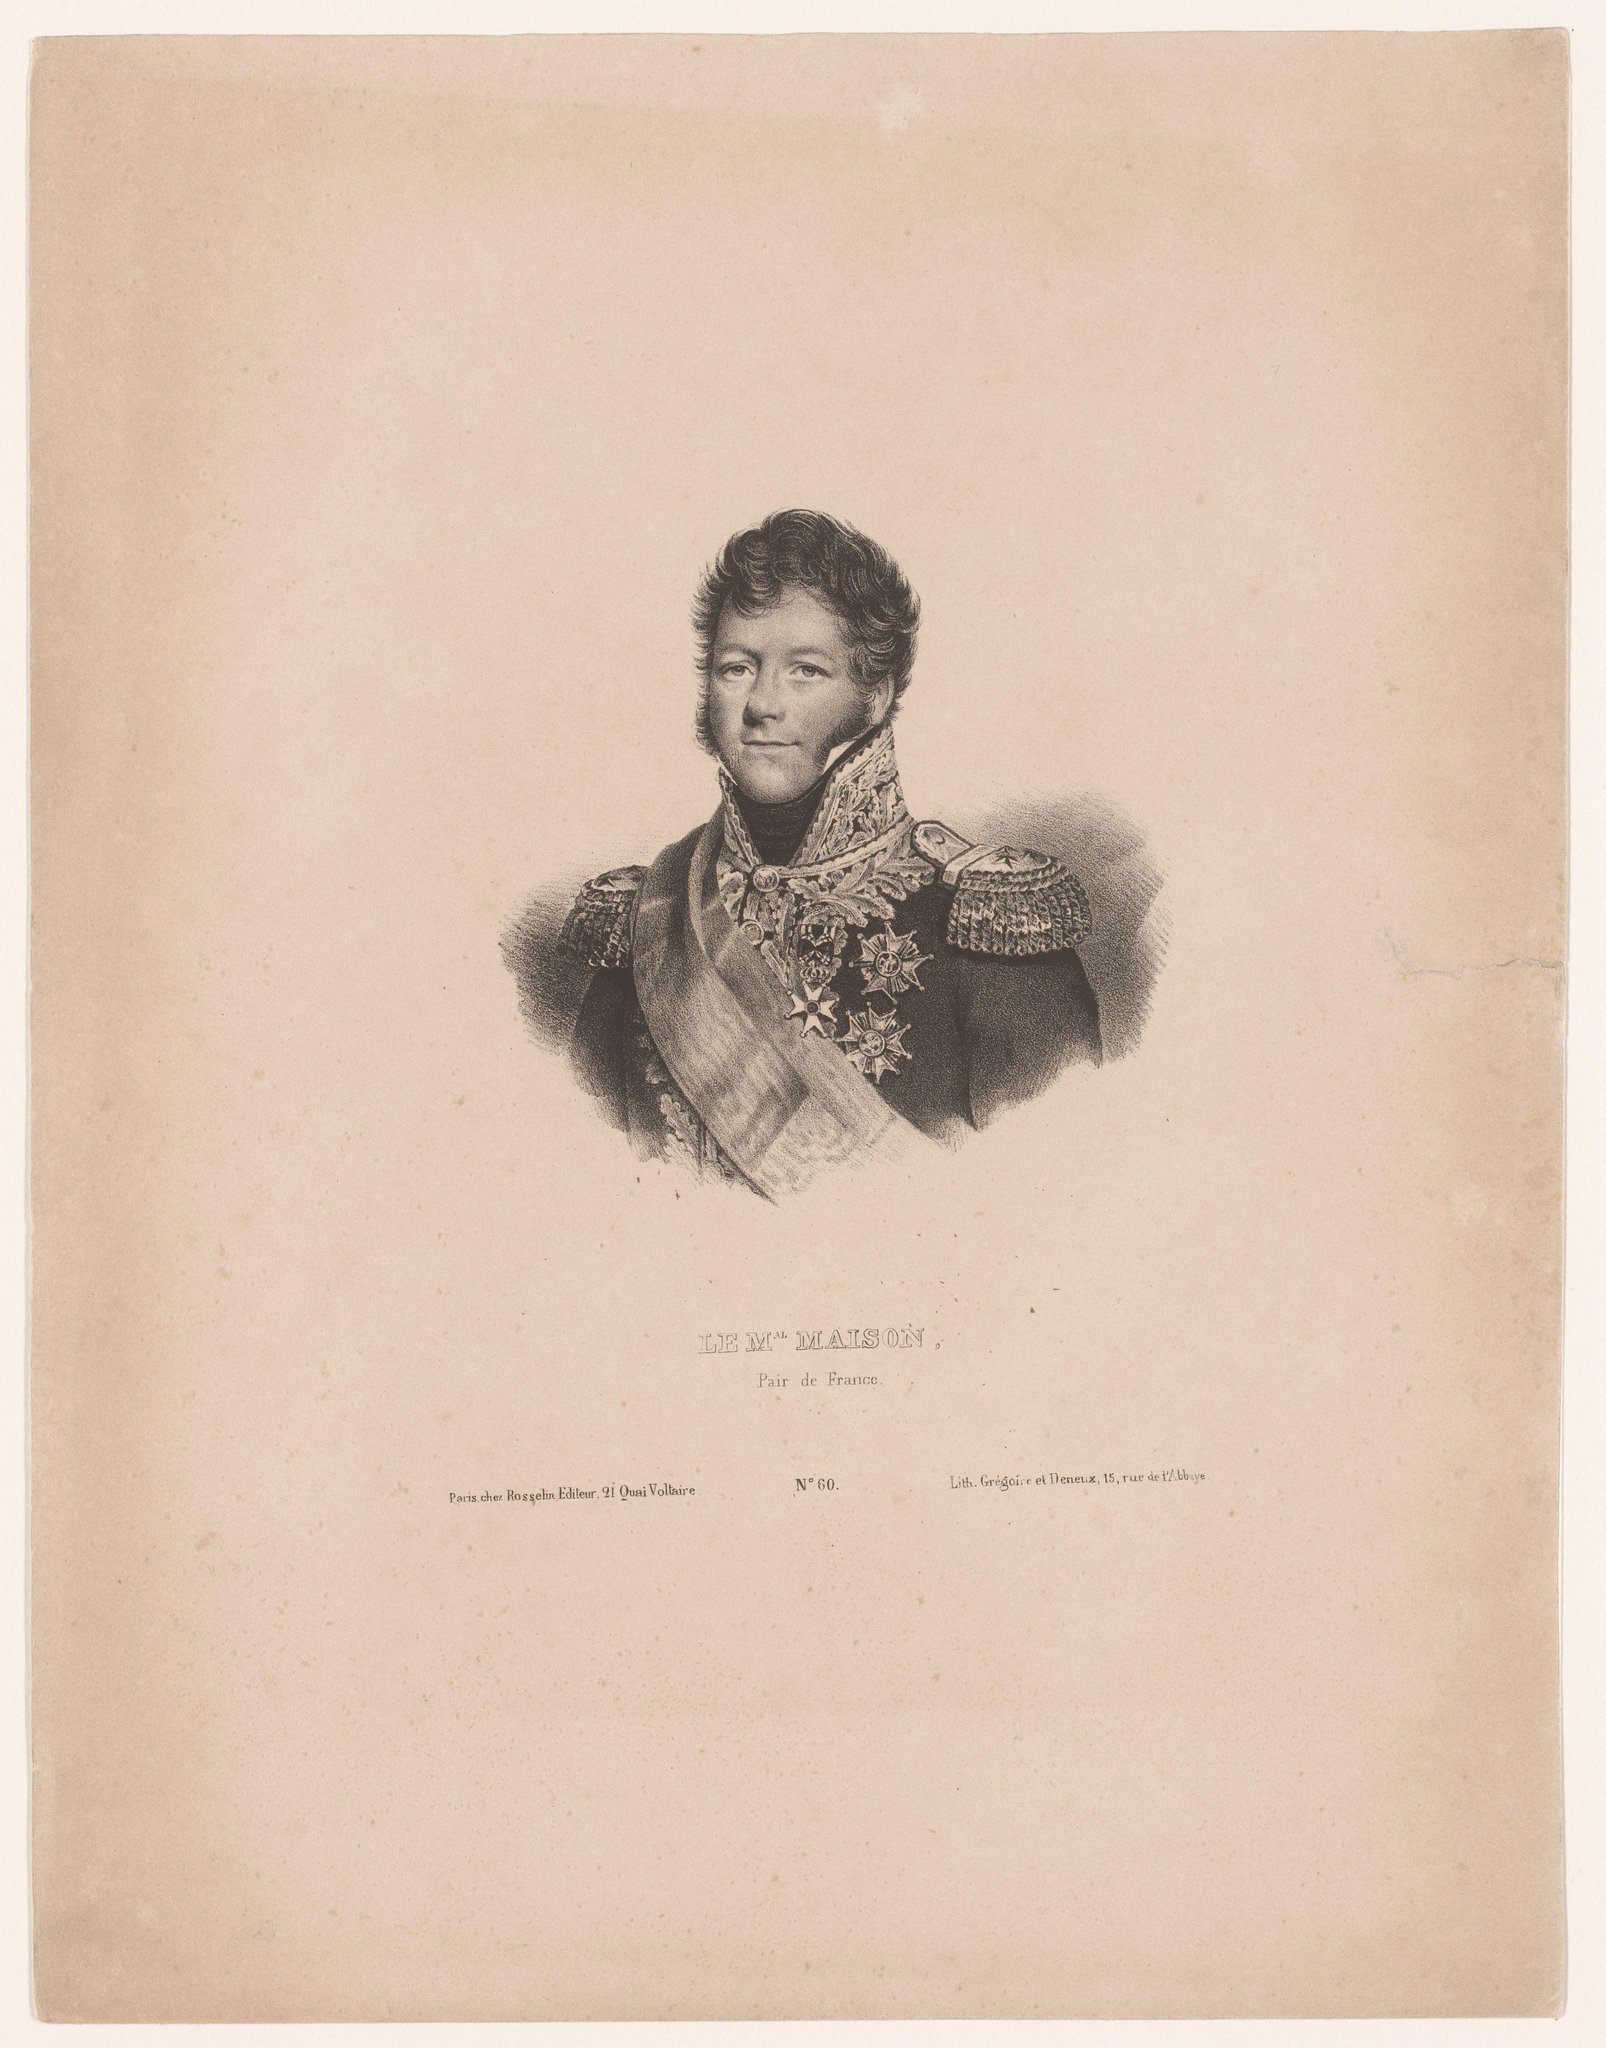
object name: print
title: Portret van Nicolas-Joseph Maison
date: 1844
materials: paper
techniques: lithograph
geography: paris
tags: paris, historical persons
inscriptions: collector's mark: Lugt 2228a